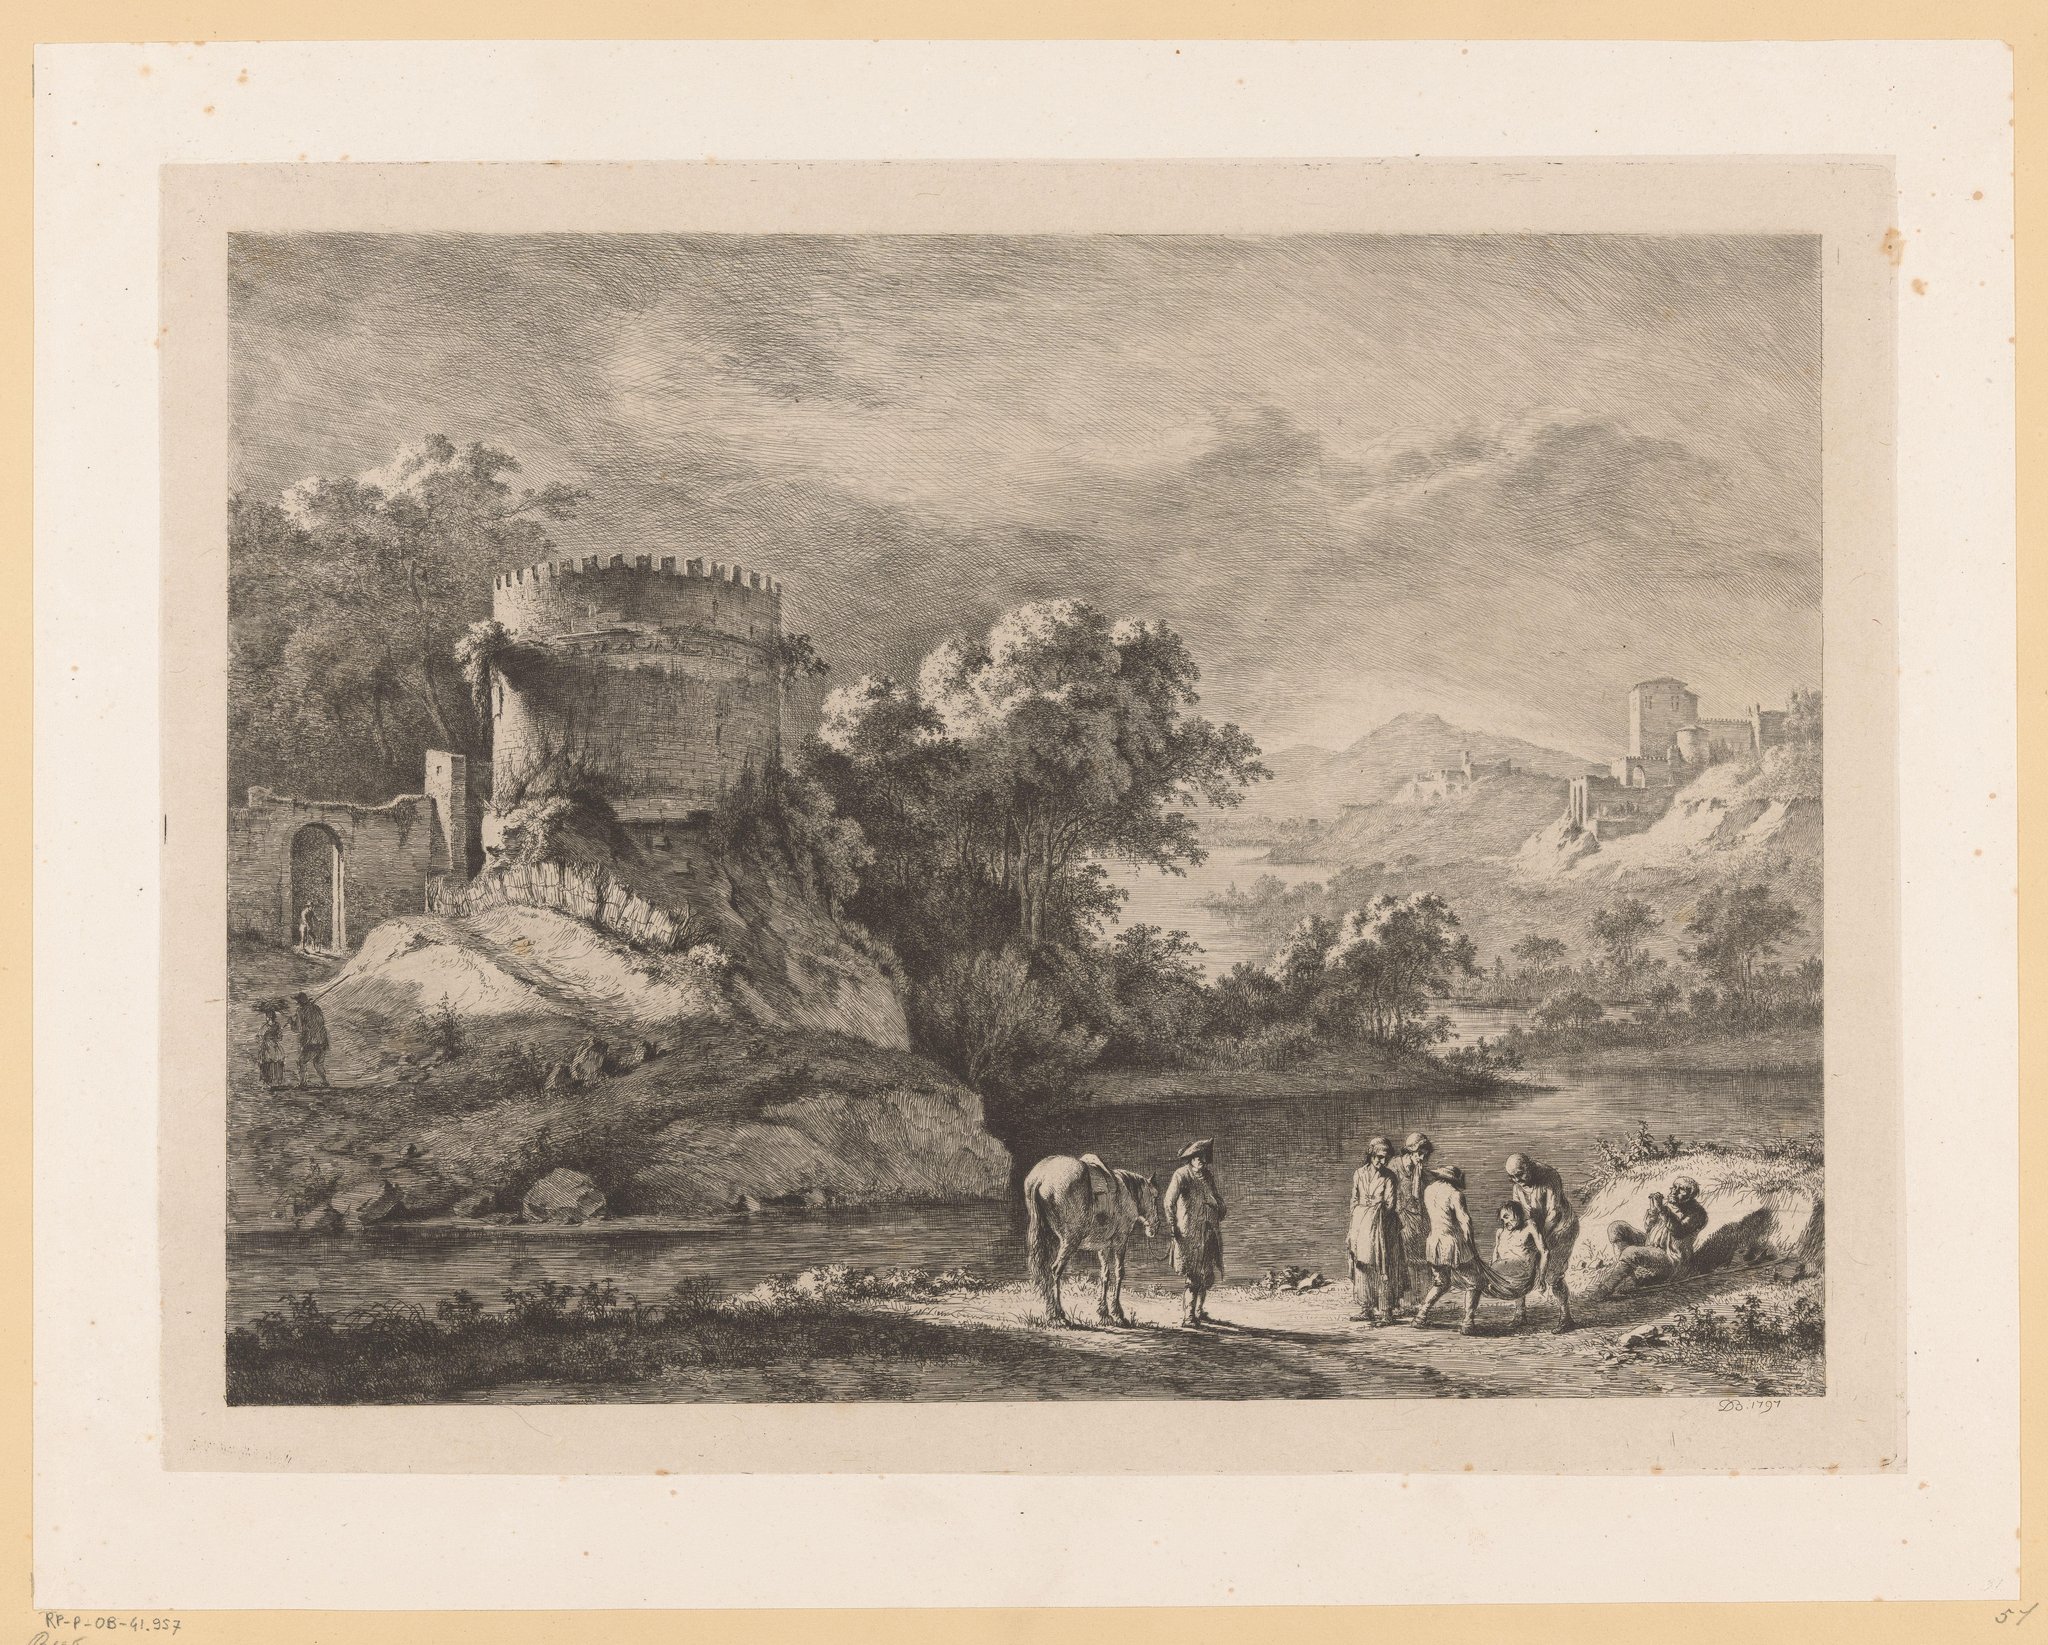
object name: print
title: Figuren in een rivierlandschap voor de tombe van Caecilia Metella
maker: jean jacques de boissieu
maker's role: draughtsman, print maker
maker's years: 1736-1810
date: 1797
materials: paper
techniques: drypoint, etching, roulette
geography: france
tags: drowned person, landscapes with waters, waterscapes, seascapes (in the temperate zone), grave, tomb, rome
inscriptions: collector's mark: Lugt 12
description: Op de voorgrond rechts wordt een verdronken man uit de rivier gehaald. Aan de overkant van de rivier links de tombe van Caecilia Metella en op de achtergrond rechts overige architectuur.